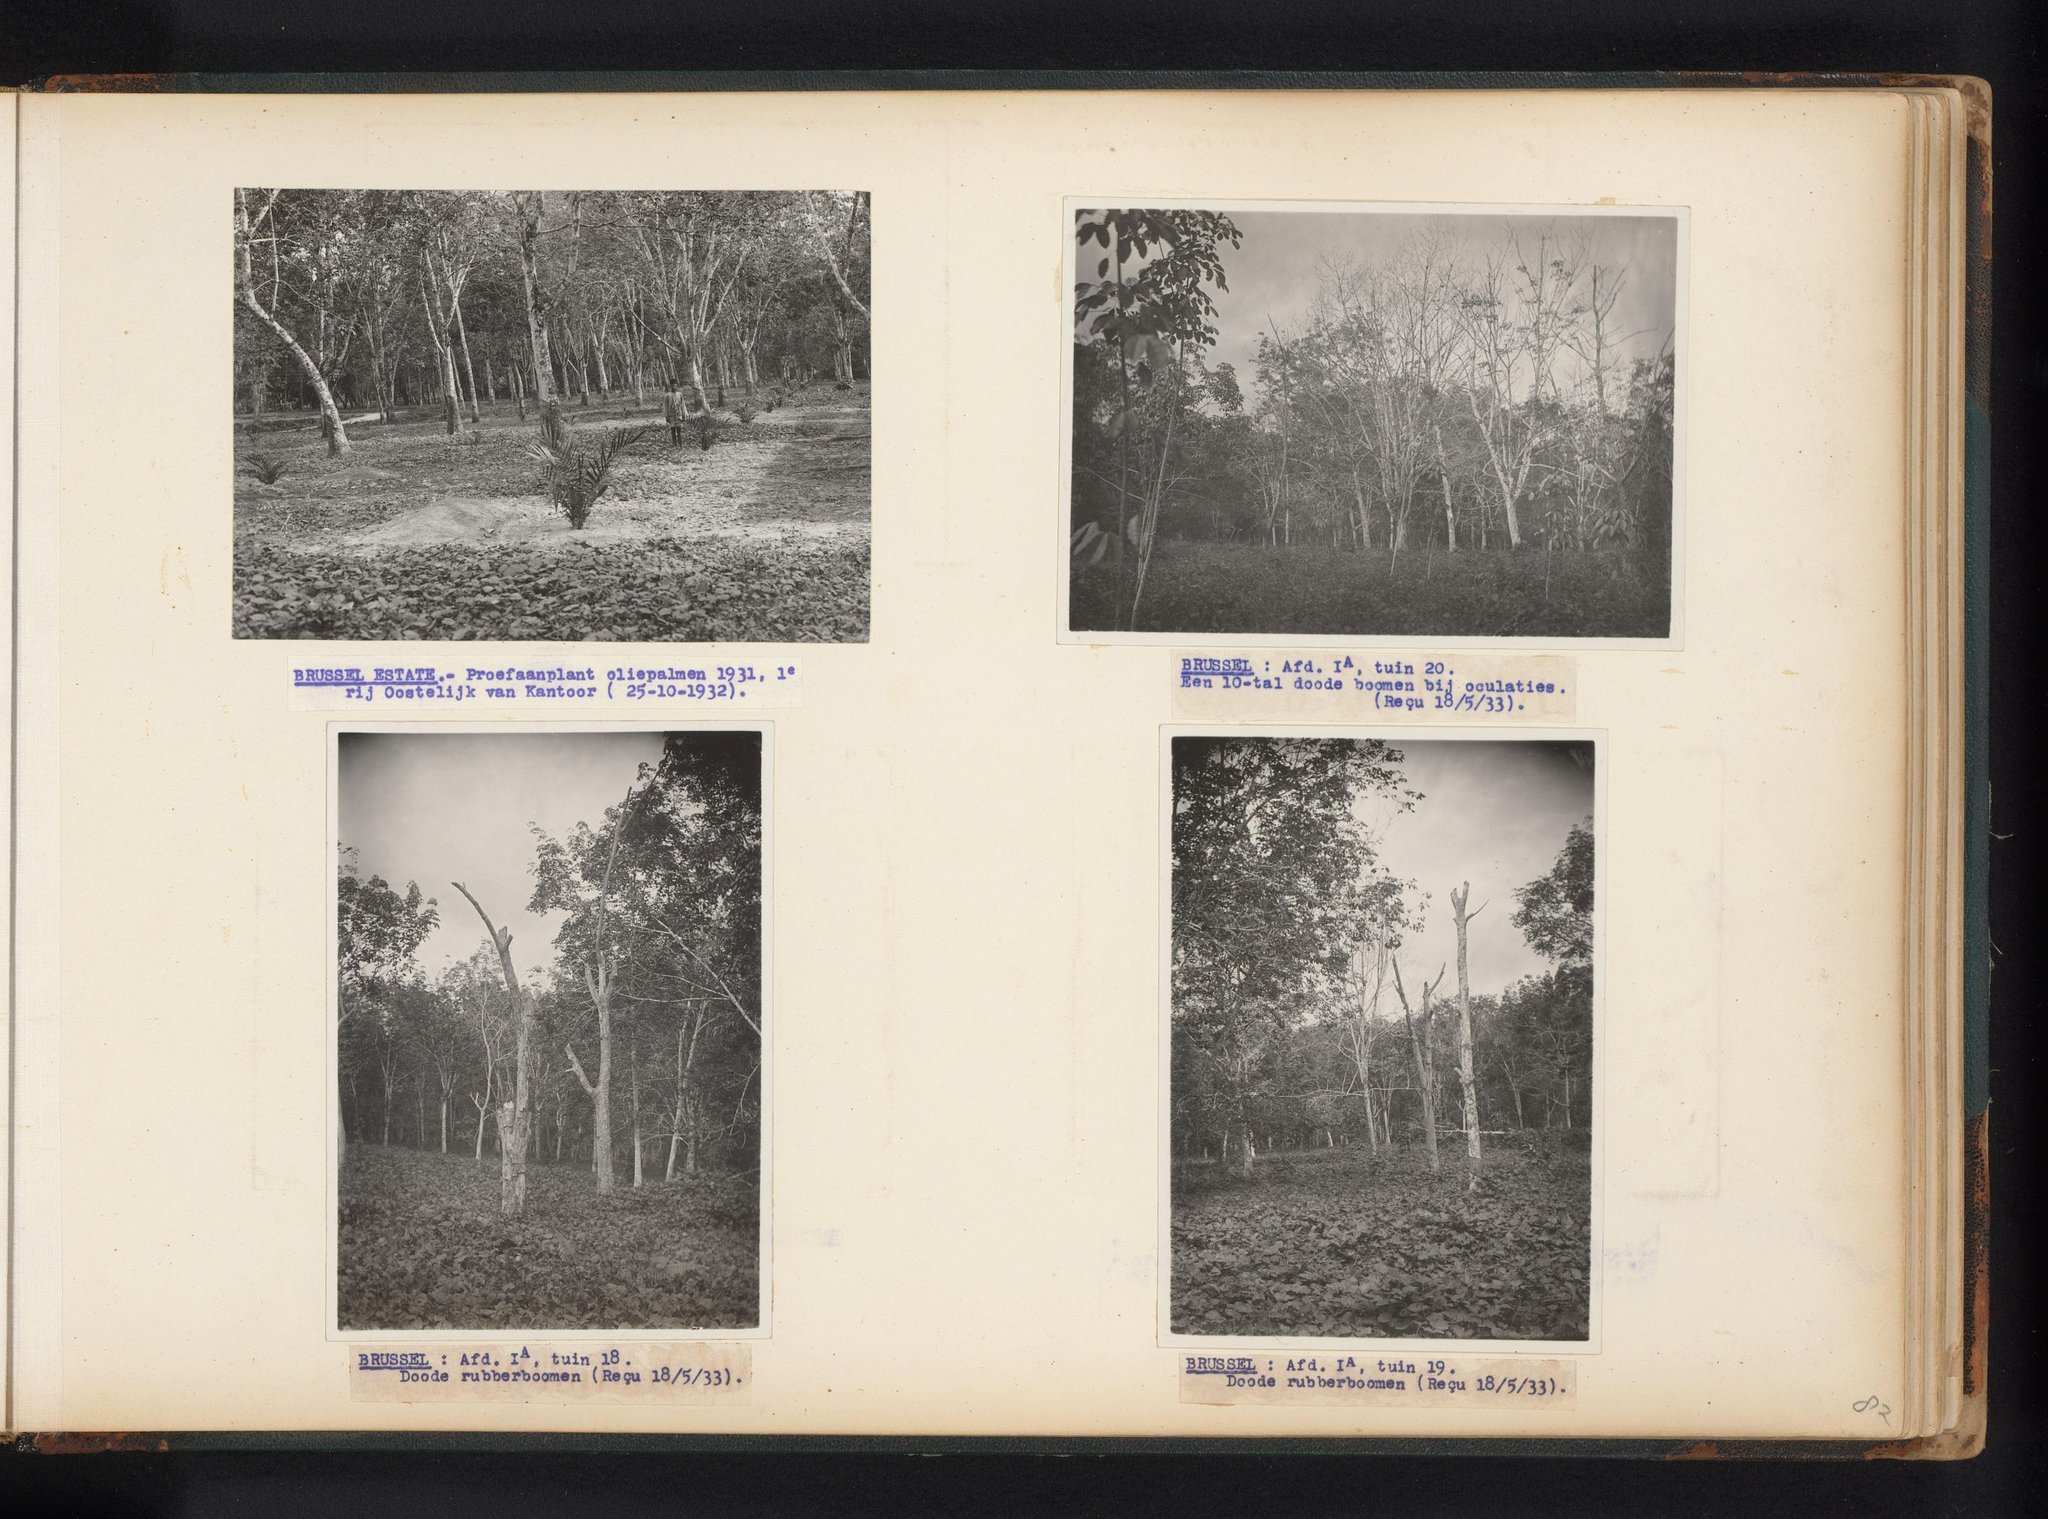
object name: album leaf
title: Rubberbomen op Brussel, 1932-1933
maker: Anonymous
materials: cardboard, photographic support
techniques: gelatin silver print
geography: sumatra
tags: plantation, (non-fruit) products of plants or trees: rubber, (non-fruit) products of plants or trees: palm oil, sumatra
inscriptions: inscription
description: Blad met vier foto's van de aanplant van oliepalmen tussen rubberbomen en van dode rubberbomen op Brussel, 1932-1933. Met etiketten met onderschriften onder de foto's. Onderdeel van het fotoalbum over de plantages Brussel en Pernantian van de Sumatra Caoutchouc Maatschappij op de Oostkust van Sumatra in de jaren 1910-1935.